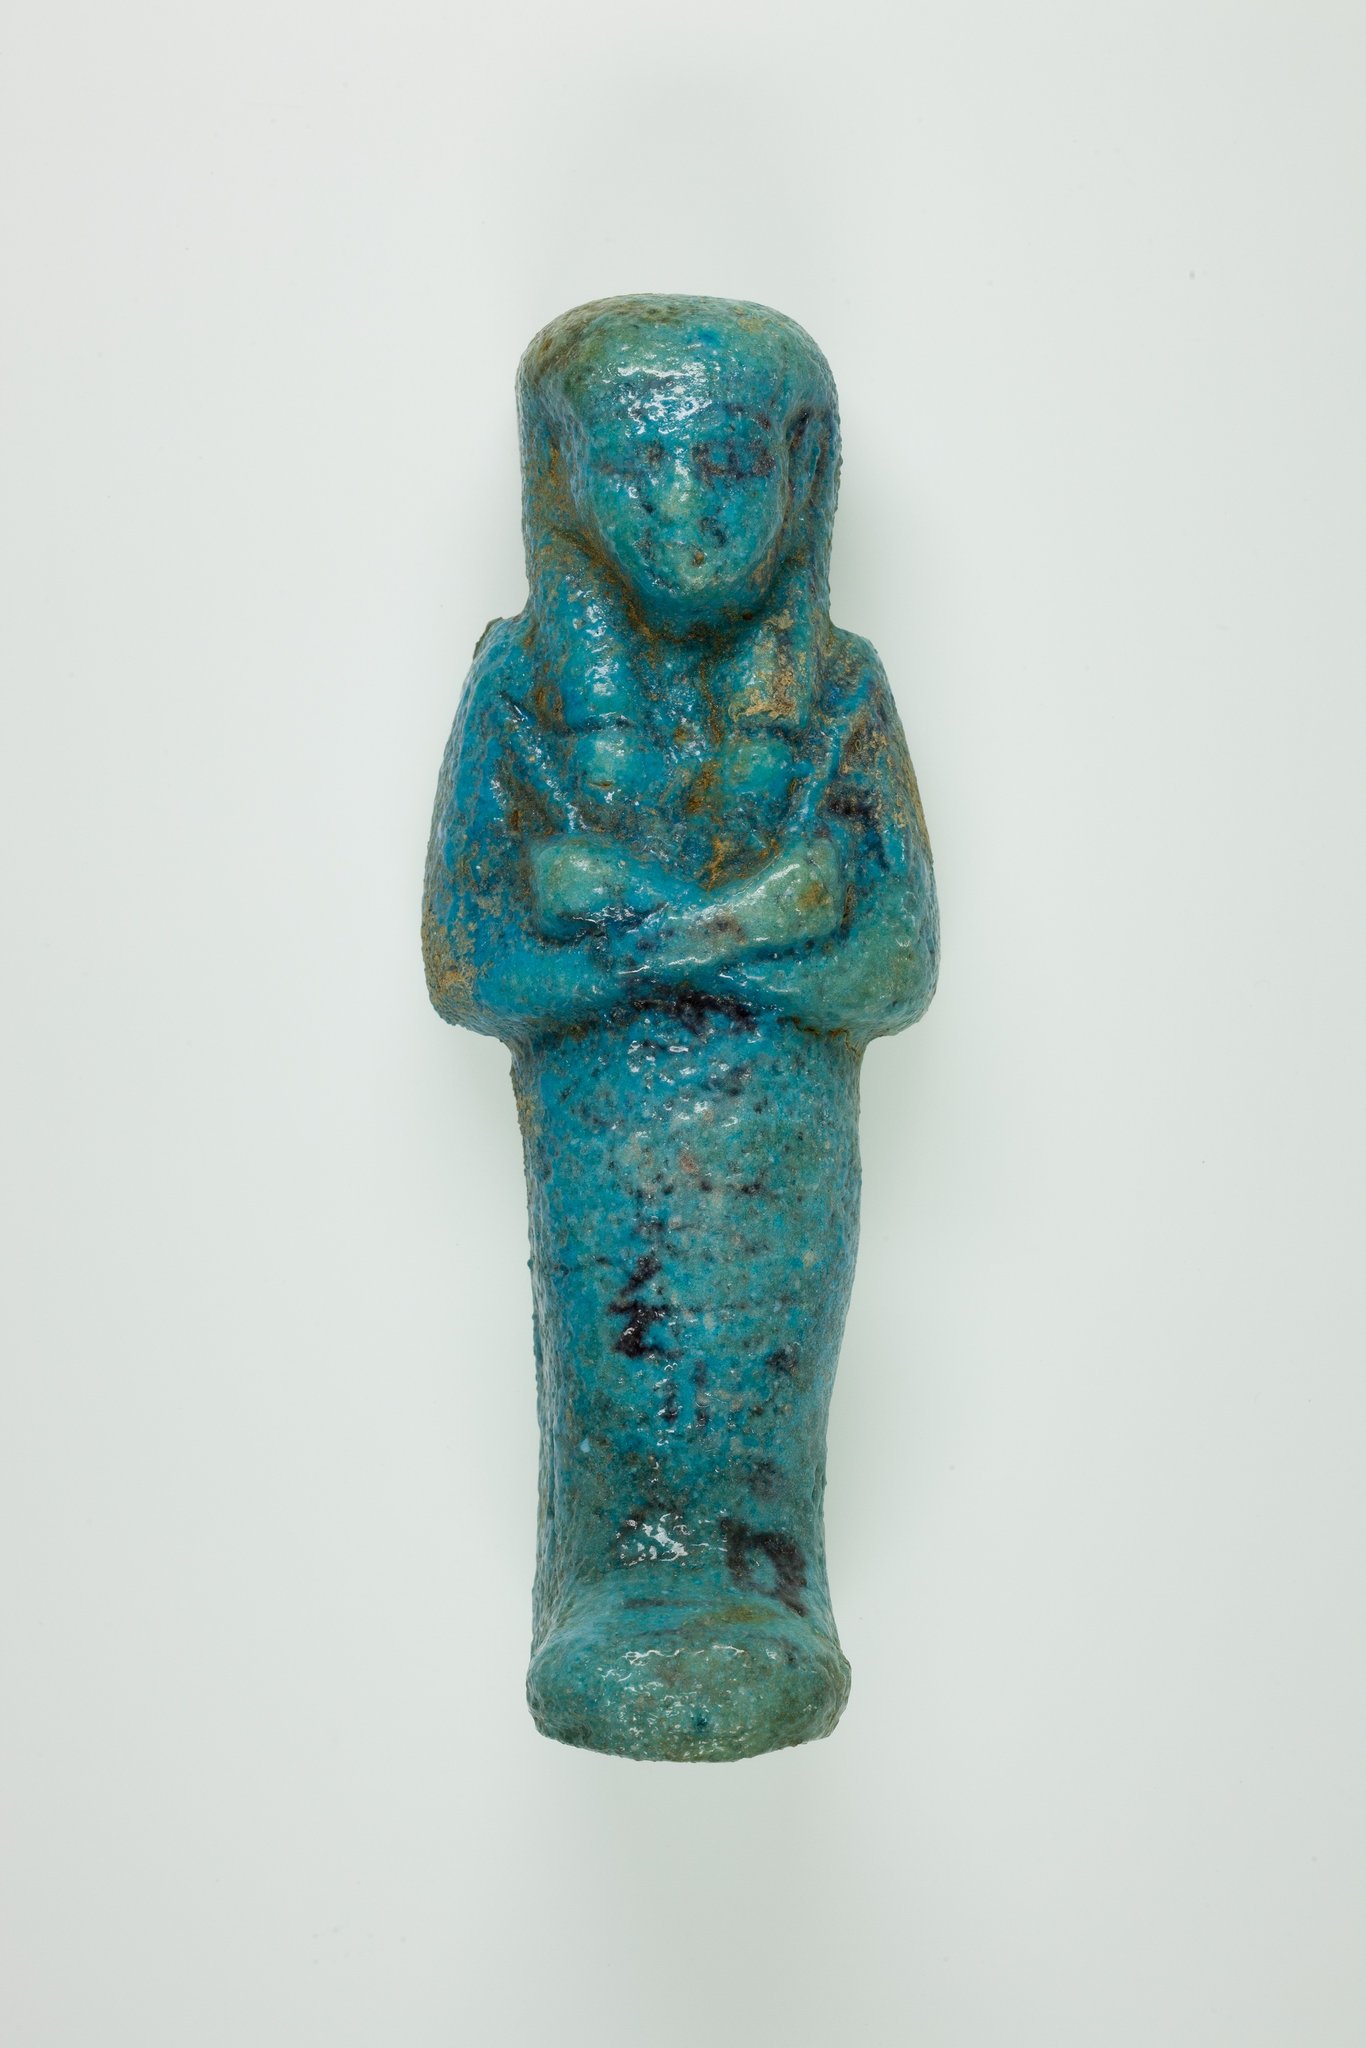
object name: worker shabti, henettawy c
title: Worker Shabti of Henettawy (C), Daughter of Isetemkheb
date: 990-970 BCE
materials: faience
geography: egypt